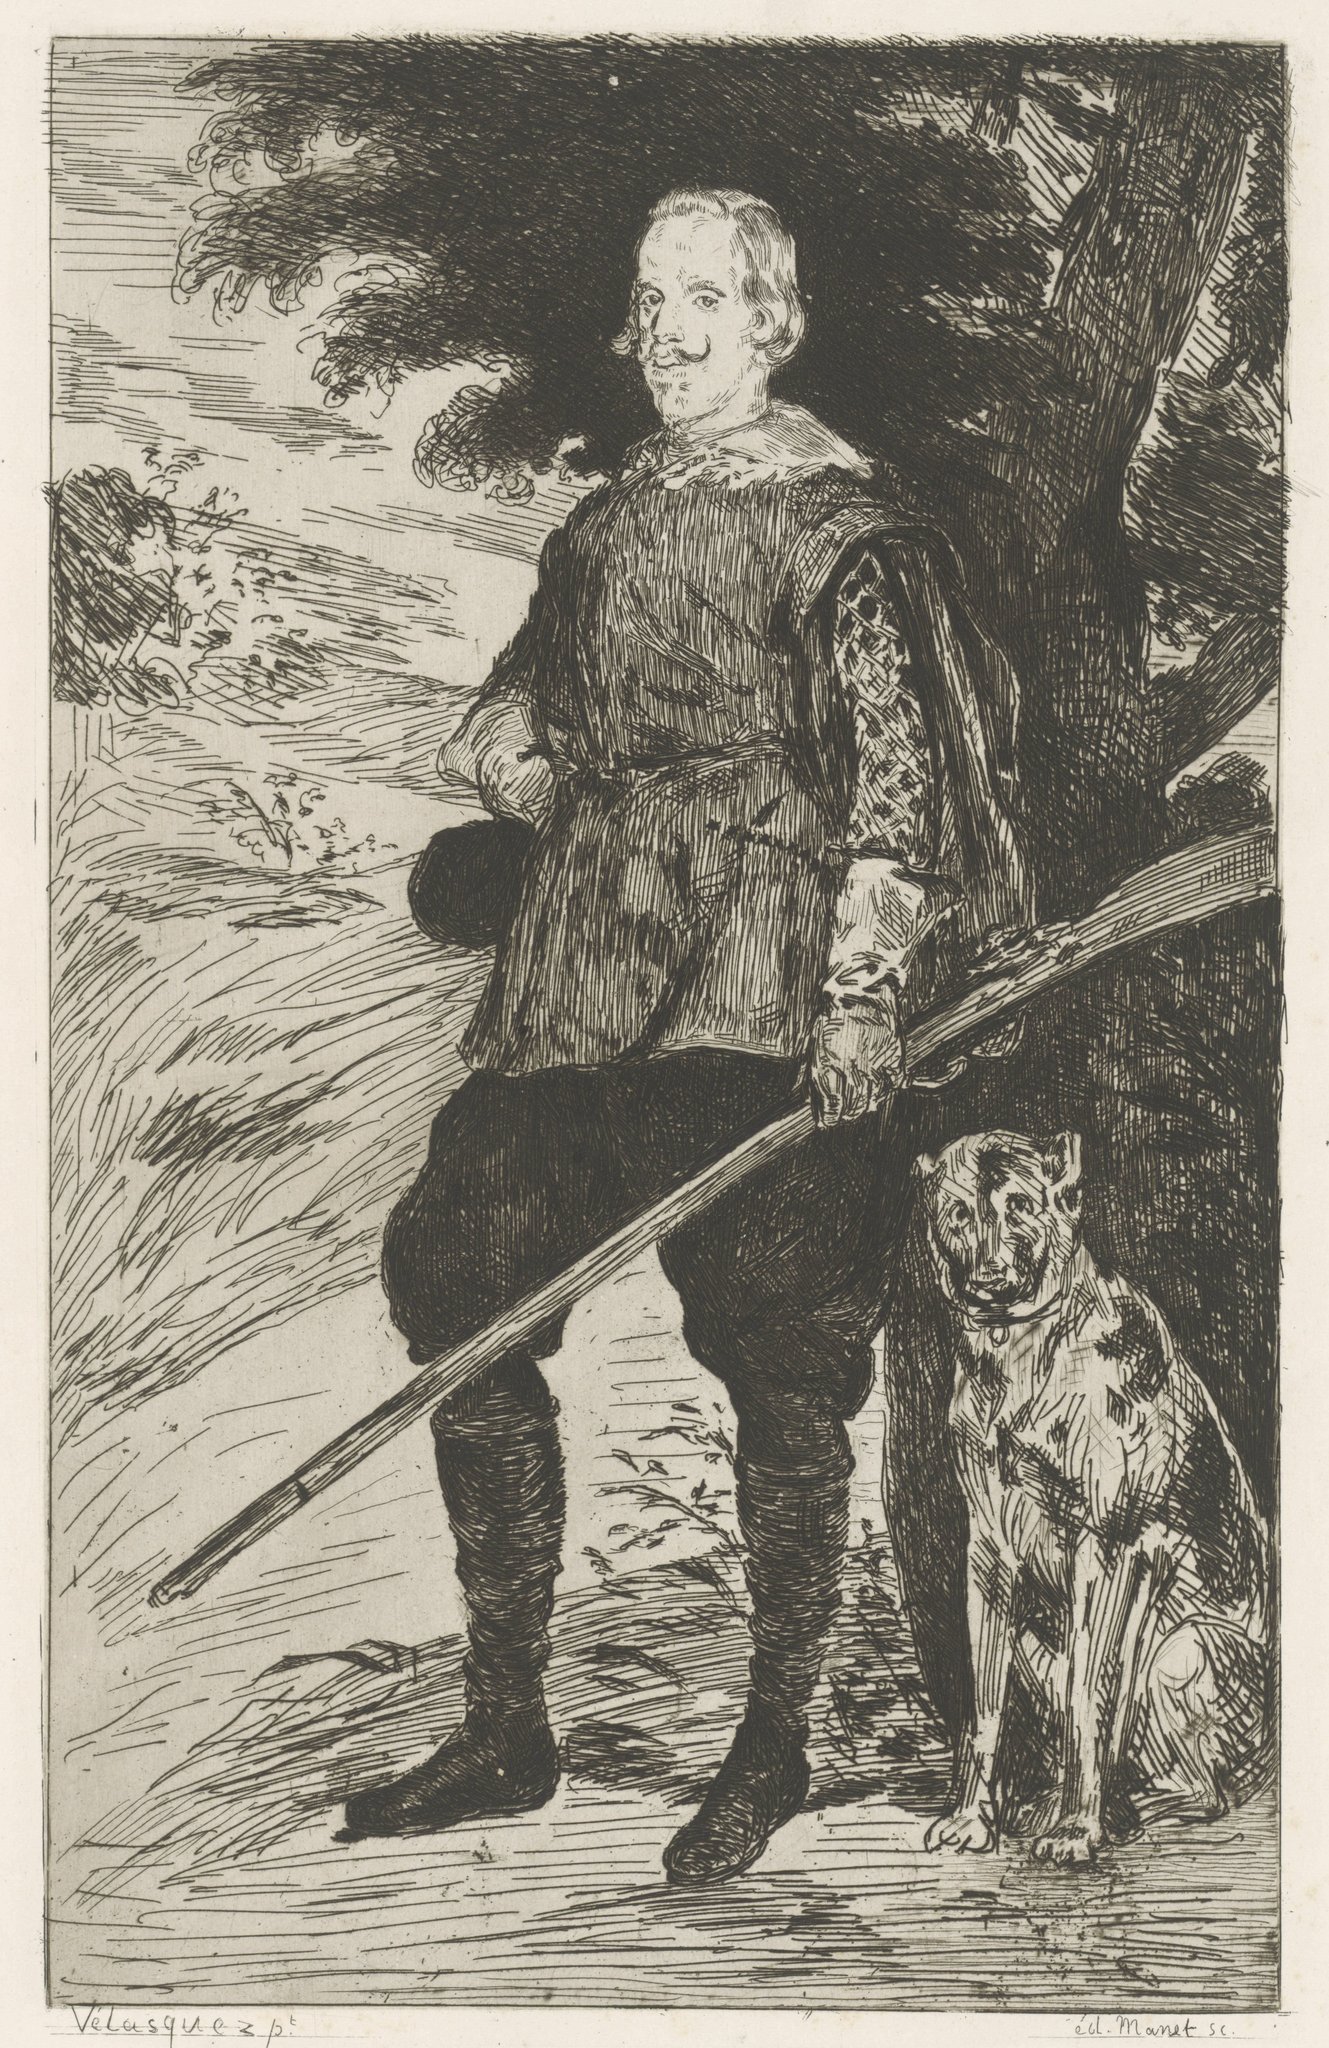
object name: print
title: Portret van Filips IV van Spanje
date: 1862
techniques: aquatint, printmaking, etching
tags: filips iv (koning van spanje), hunting dogs, hunter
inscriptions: collector's mark: Lugt 2228, collector's mark: Lugt 2760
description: Prent naar een schilderij met het portret van Filips IV dat in de tijd van Manet werd toegeschreven aan Velázquez maar tegenwoordig op naam staat van zijn medewerker Mazo (Louvre).